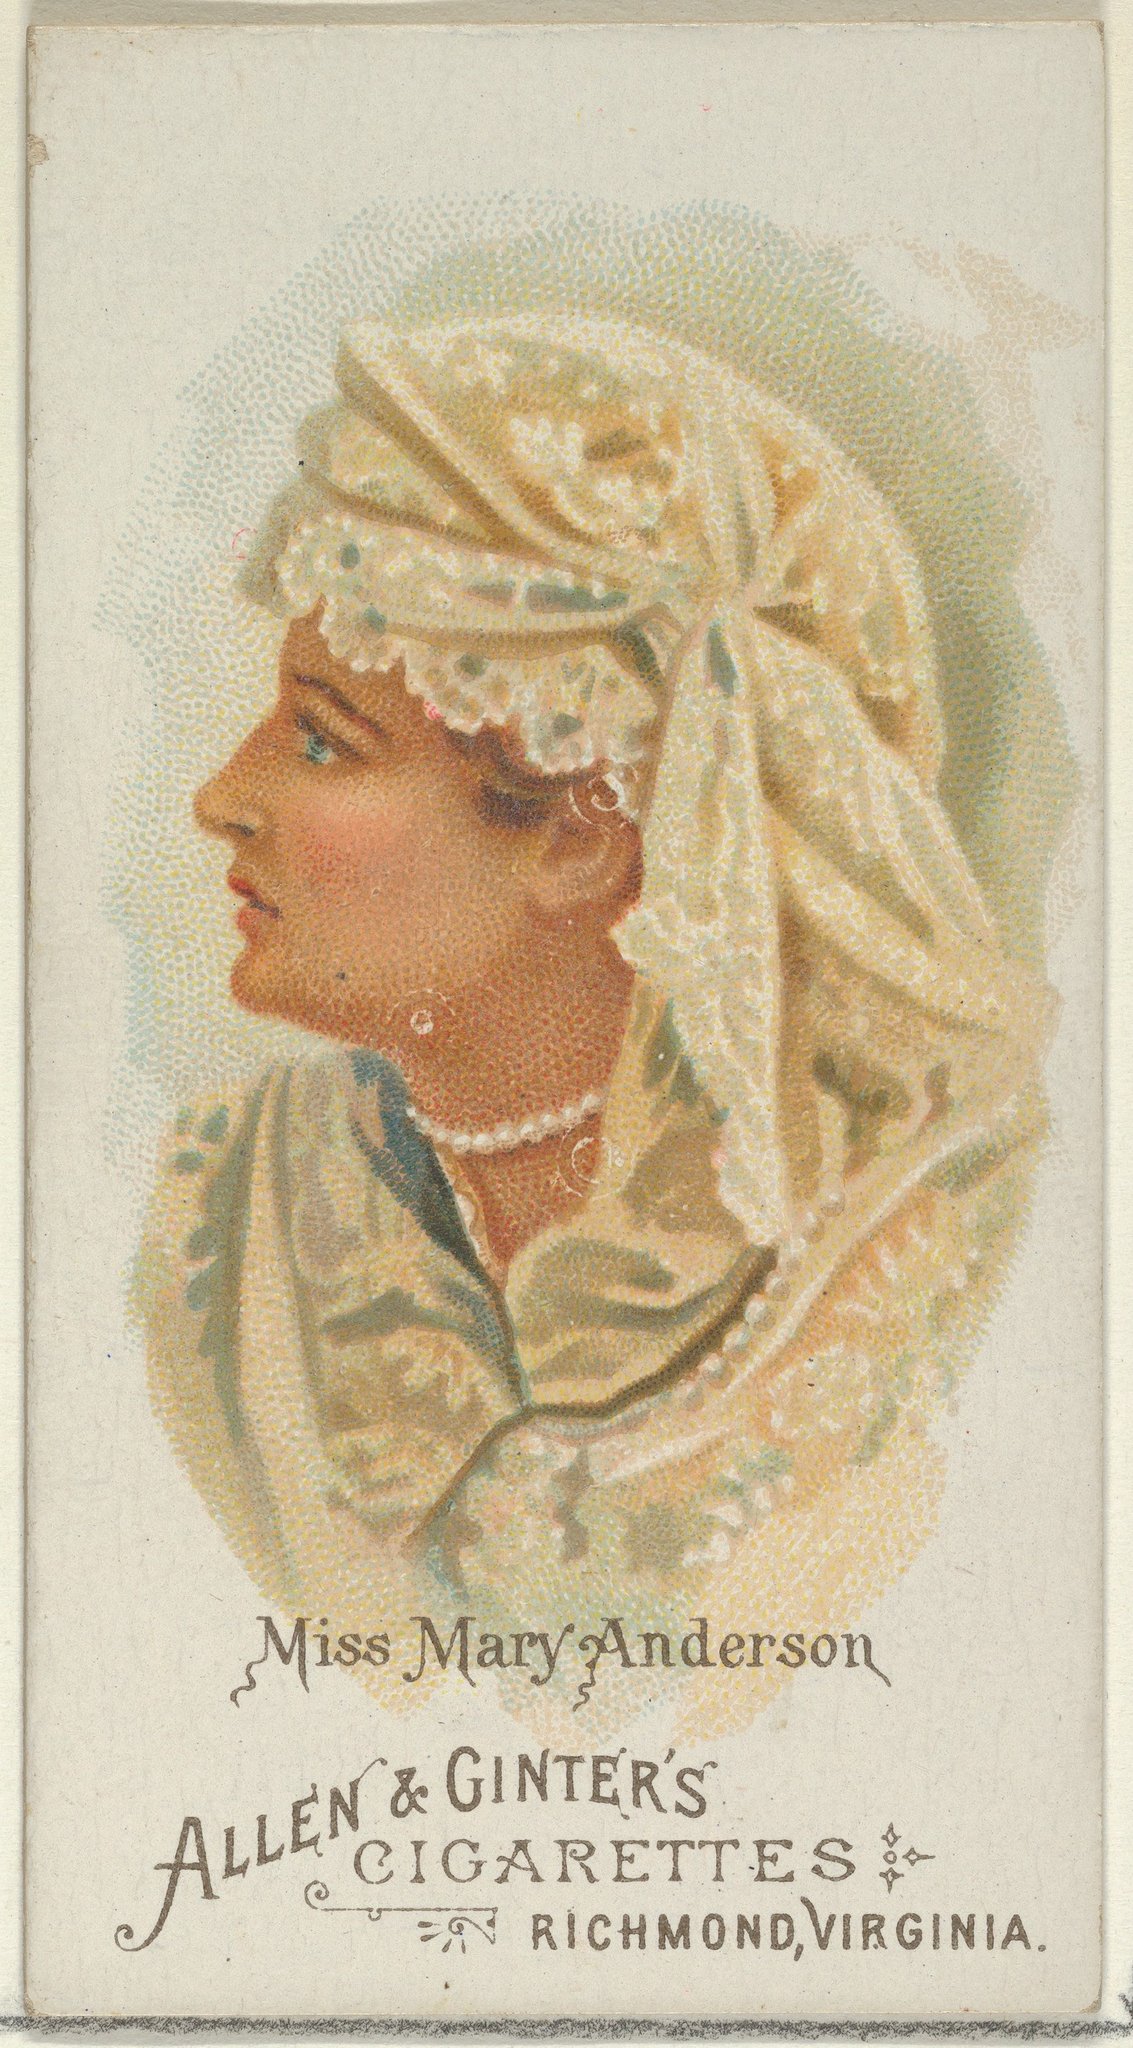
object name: print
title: Miss Mary Anderson, from World's Beauties, Series 1 (N26) for Allen & Ginter Cigarettes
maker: allen & ginter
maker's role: publisher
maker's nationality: american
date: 1888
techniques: color lithograph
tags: women